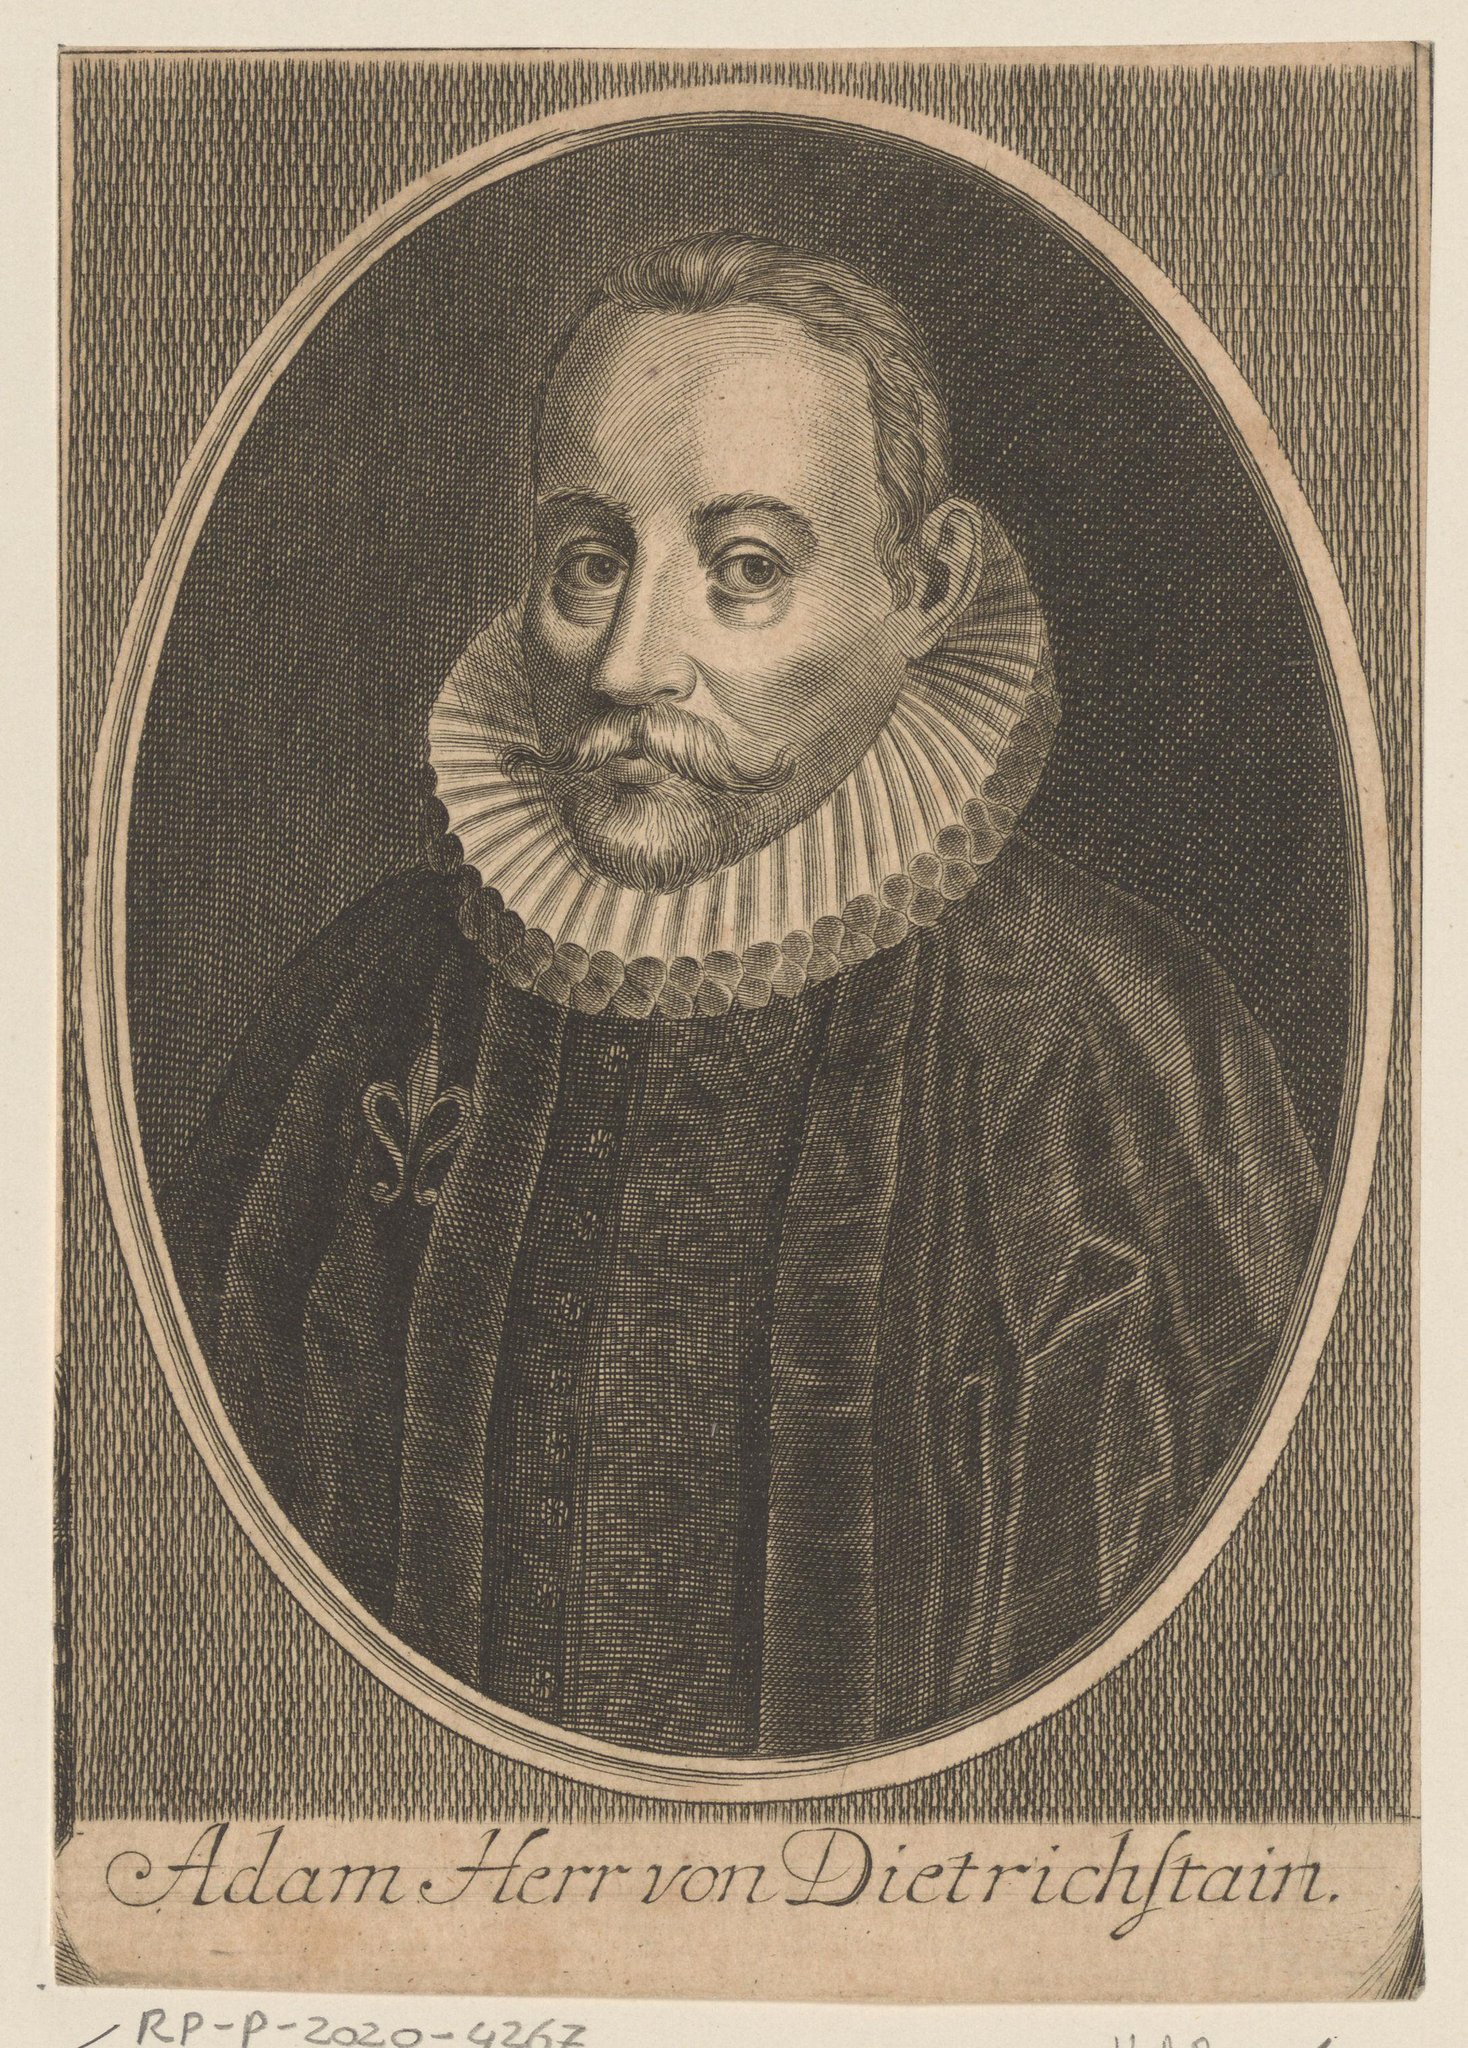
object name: print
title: Portret van Adam von Dietrichstein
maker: Anonymous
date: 1721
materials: paper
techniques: engraving, etching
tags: historical persons, diplomacy, diplomat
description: Prent mogelijk uit: Khevenhüller, Franz Christoph. Conterfet Kupfferstich (...). Leipzig: Moritz Georg Weidmann, 1721.